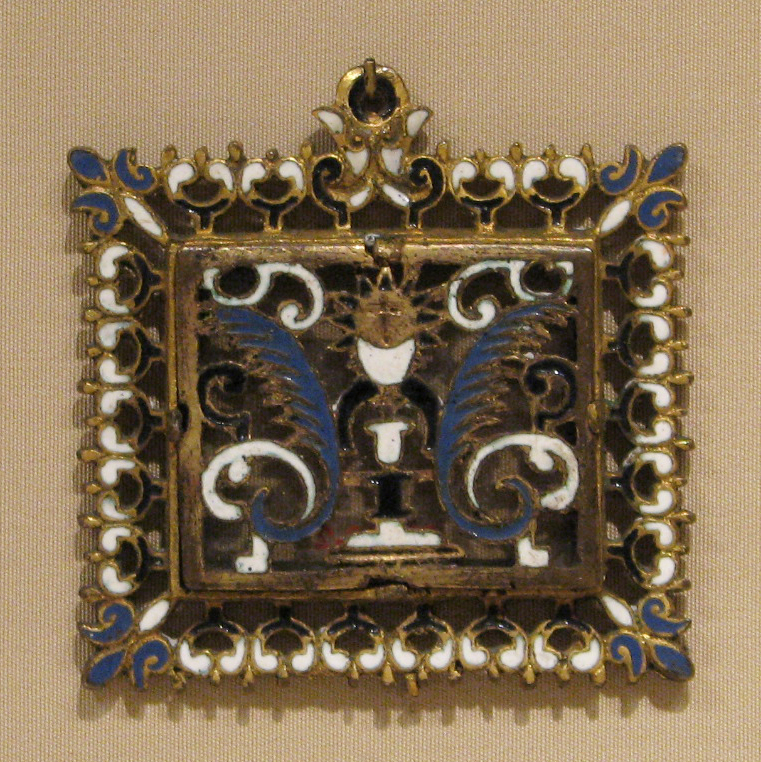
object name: pilgrim's badge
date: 1601-1650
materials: brass, enamel, gilt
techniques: enamel